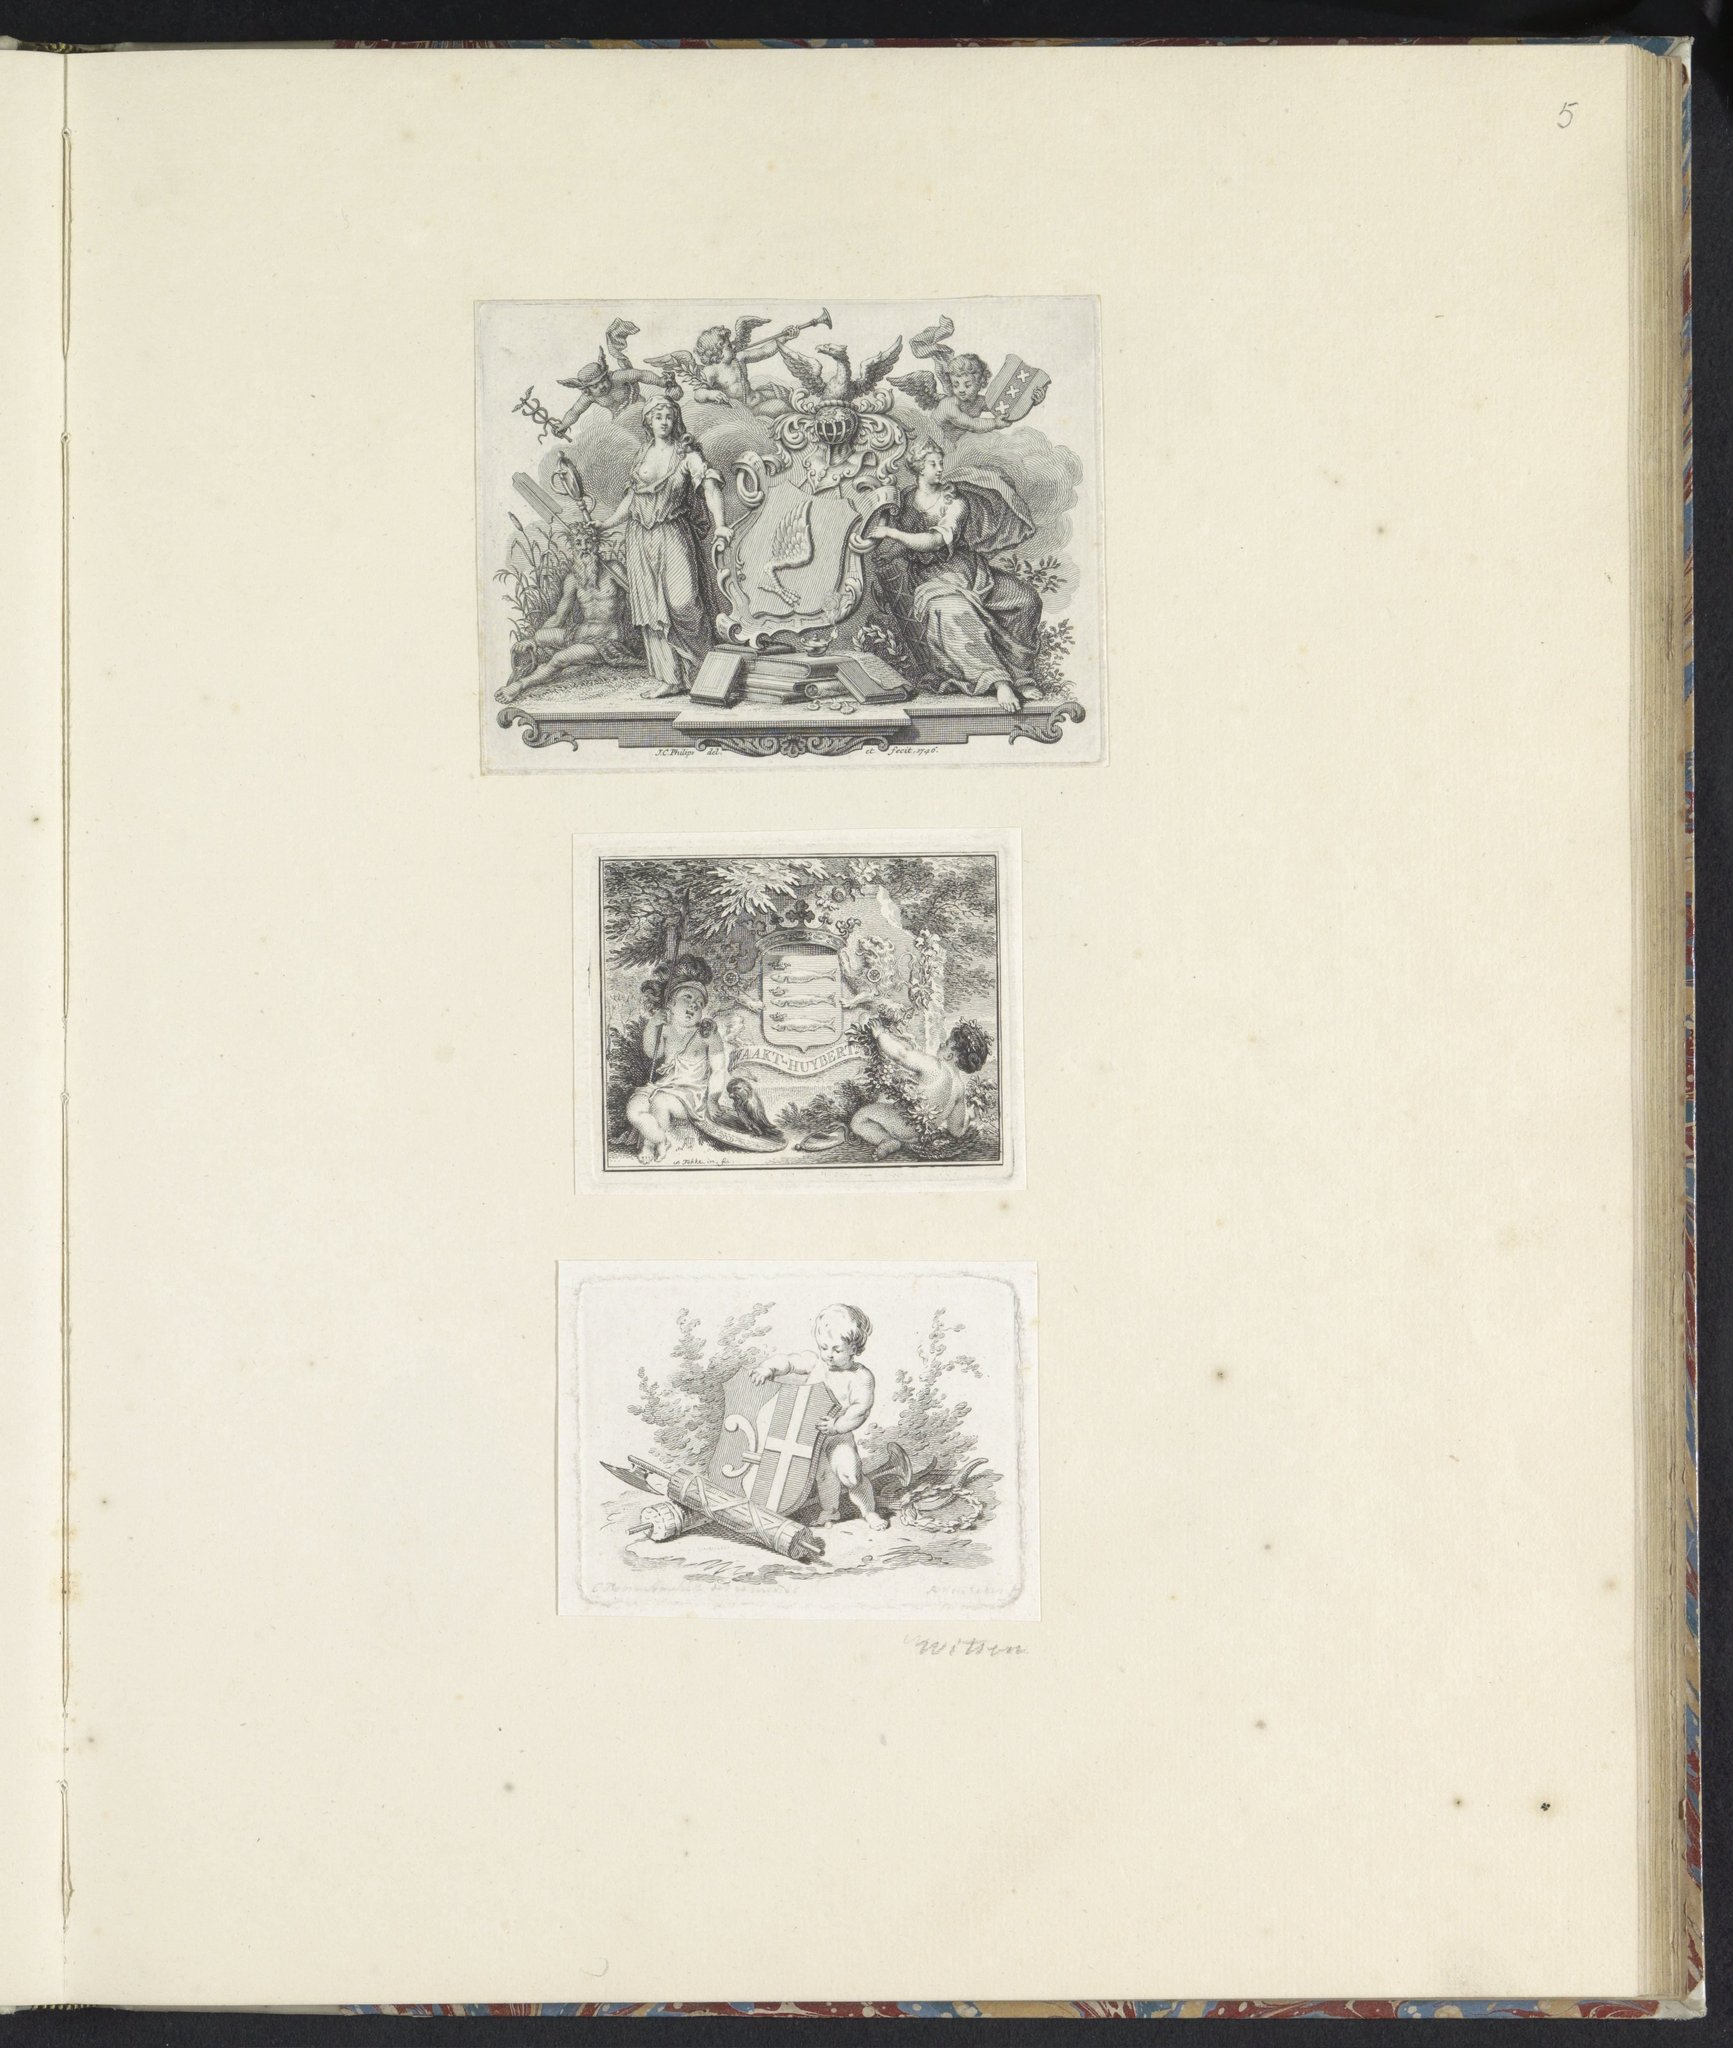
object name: album leaf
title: Drie vignetten met wapenschilden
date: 1722-1784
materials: paper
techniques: engraving, etching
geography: amsterdam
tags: wisdom; 'sapienza', 'sapienza humana', 'sapienza vera' (ripa), vignette, armorial bearing, heraldry, prudentia (prudence) as roman personification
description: Drie voorstellingen op een albumblad. Bovenaan een schild met een gevleugelde adelaarspoot op een stapel boeken en papieren, geflankeerd door de personificaties van Voorzichtigheid (met spiegel en slang) en Rechtvaardigheid (met fasces). Daarbij onder meer het wapen van Amsterdam en de riviergod van de Amstel. In het midden een wapen met drie gekroonde en gekaakte haringen met twee putti als de personificaties van Wijsheid en Voorzichtigheid. Op een banderol de tekst: Waakt-Huybert. Onderaan een staande putto met het familiewapen van Witsen. Op de grond een fasces, trompet en lier. De prenten maken deel uit van een album.